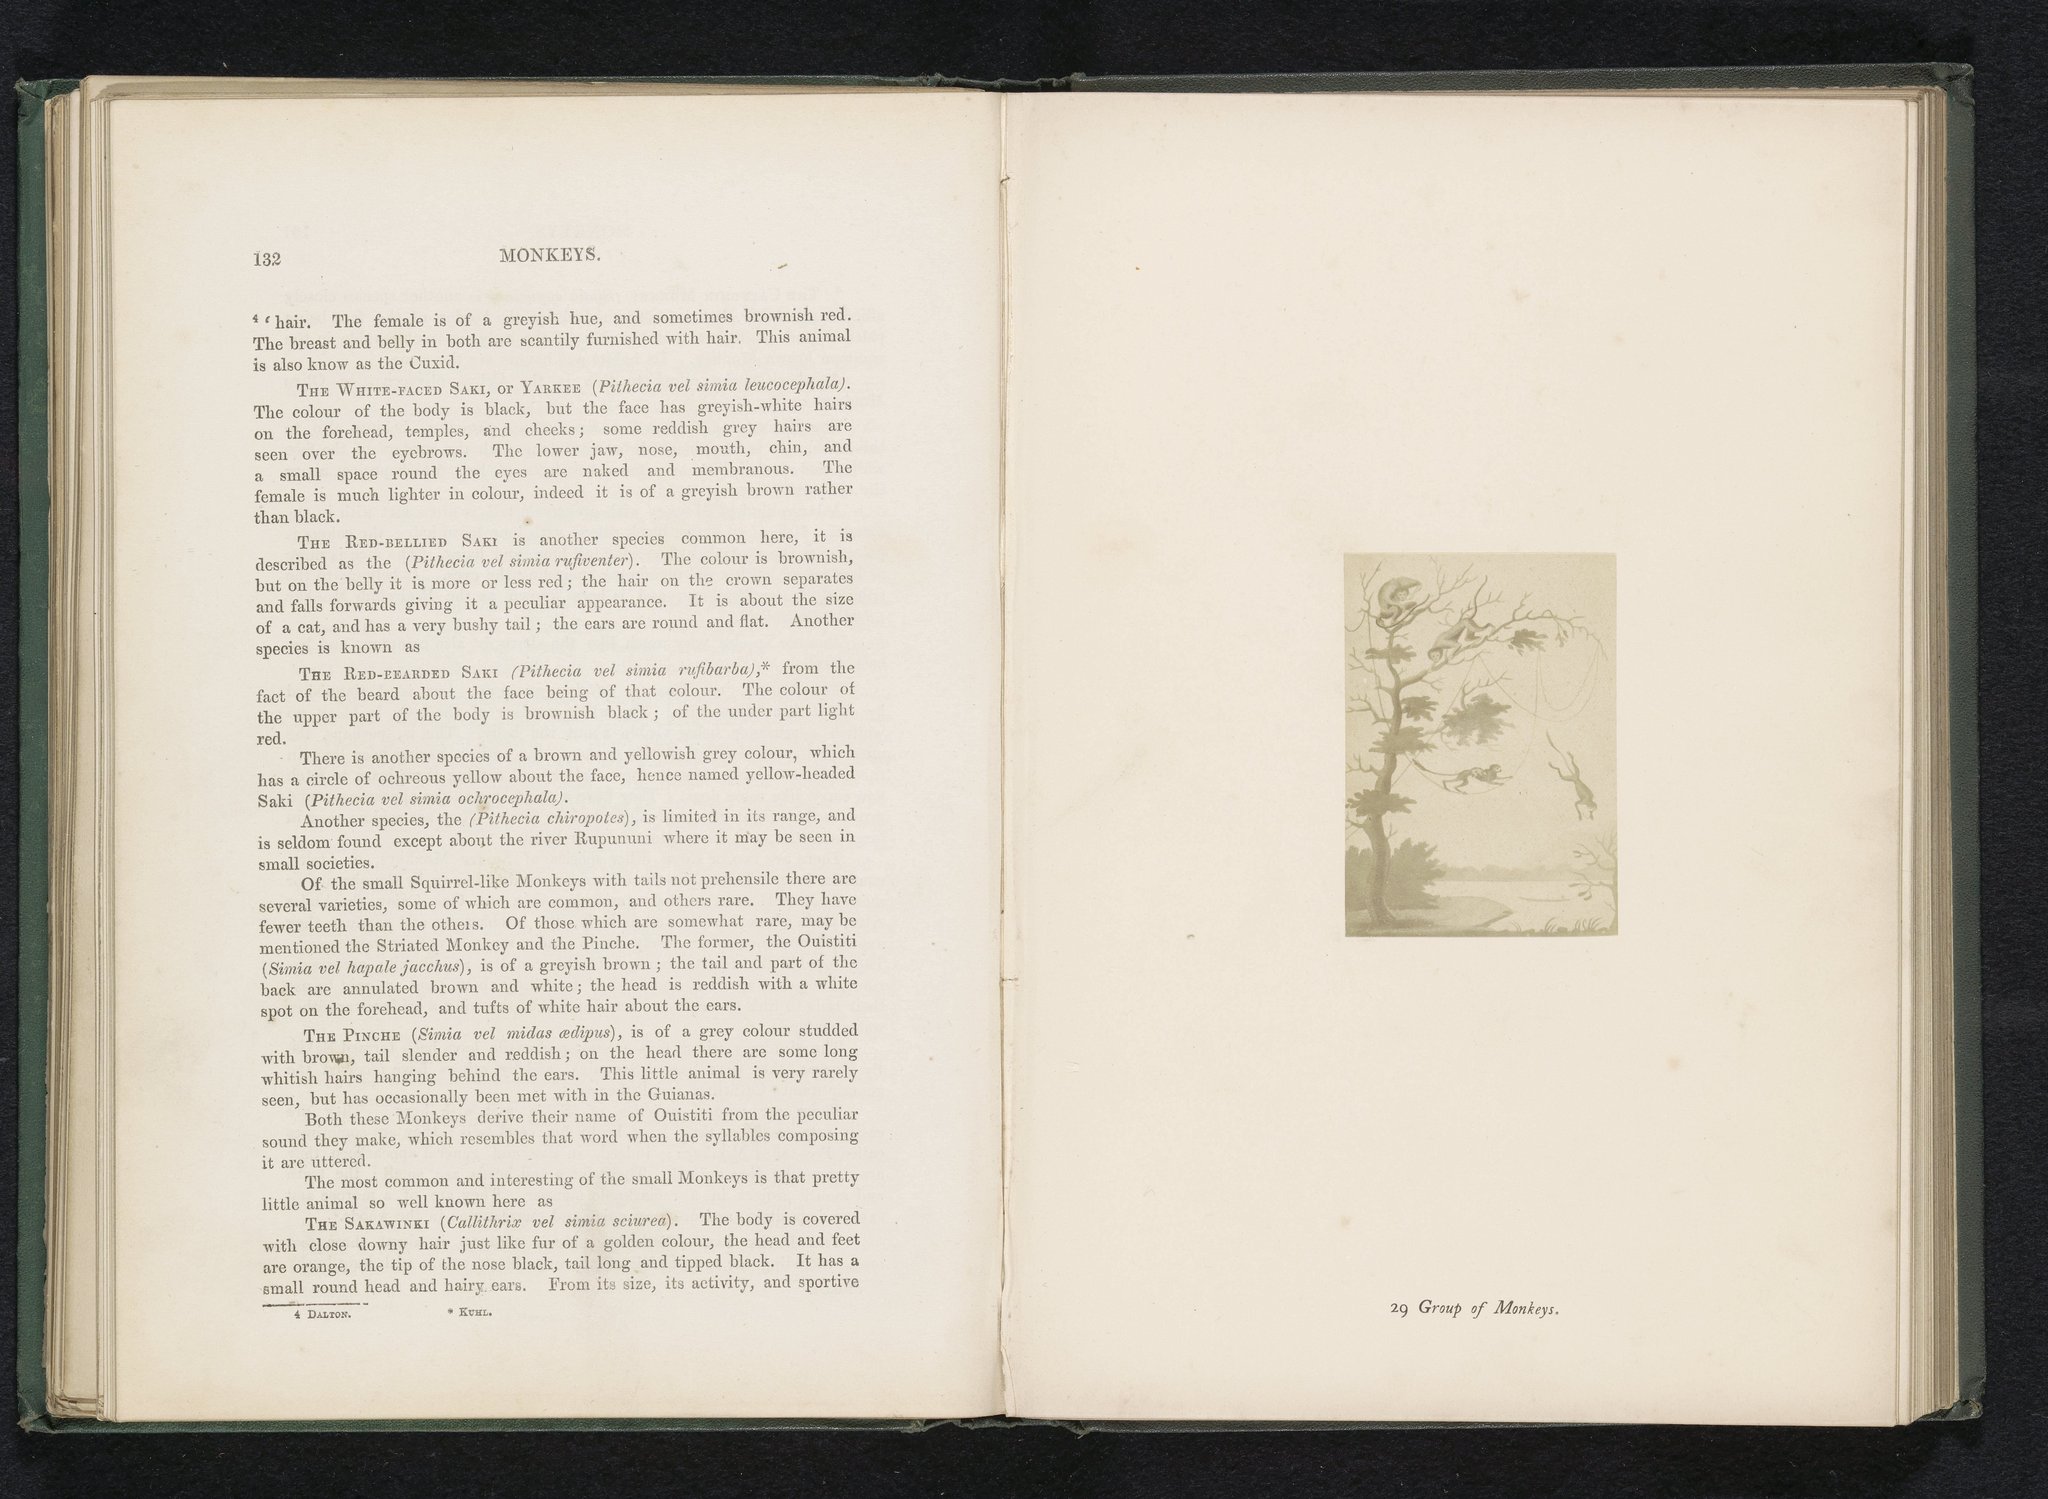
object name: photograph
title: Group of Monkeys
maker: Anonymous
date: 1856-1866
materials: photographic support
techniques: albumen print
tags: monkeys, apes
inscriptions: number: ‘29’